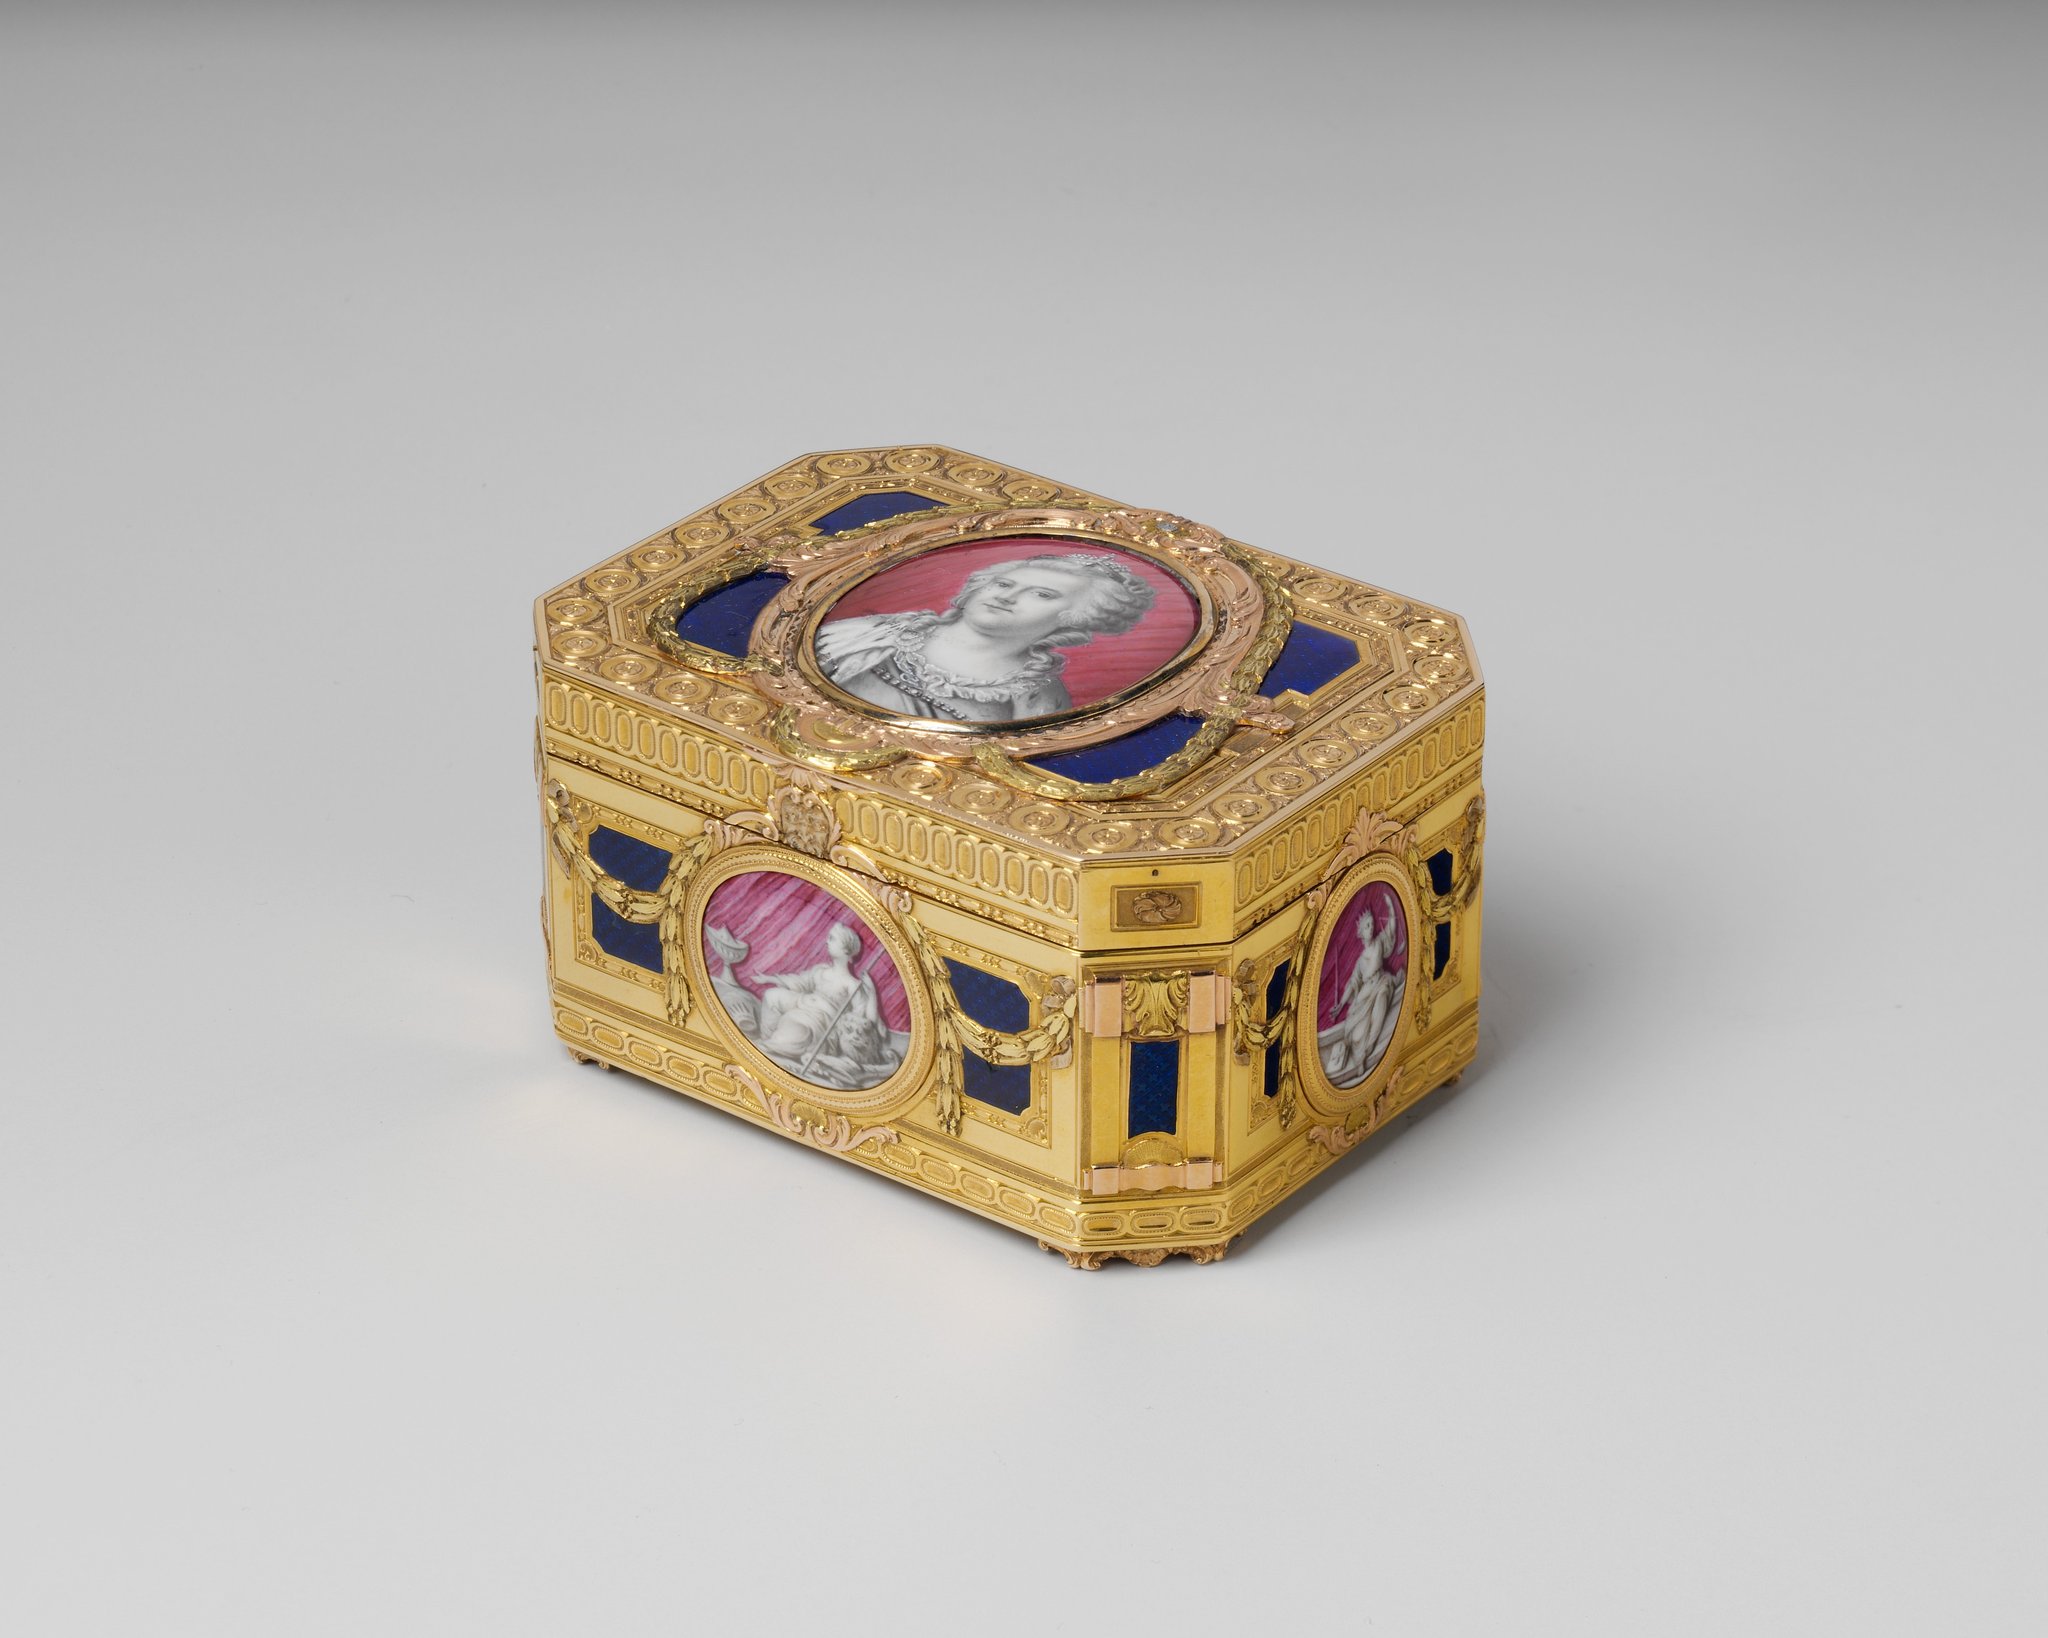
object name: snuffbox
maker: pierre-françois-mathis de beaulieu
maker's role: maker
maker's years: 1752-1792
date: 1764-1765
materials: enamel, gold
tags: portraits,women